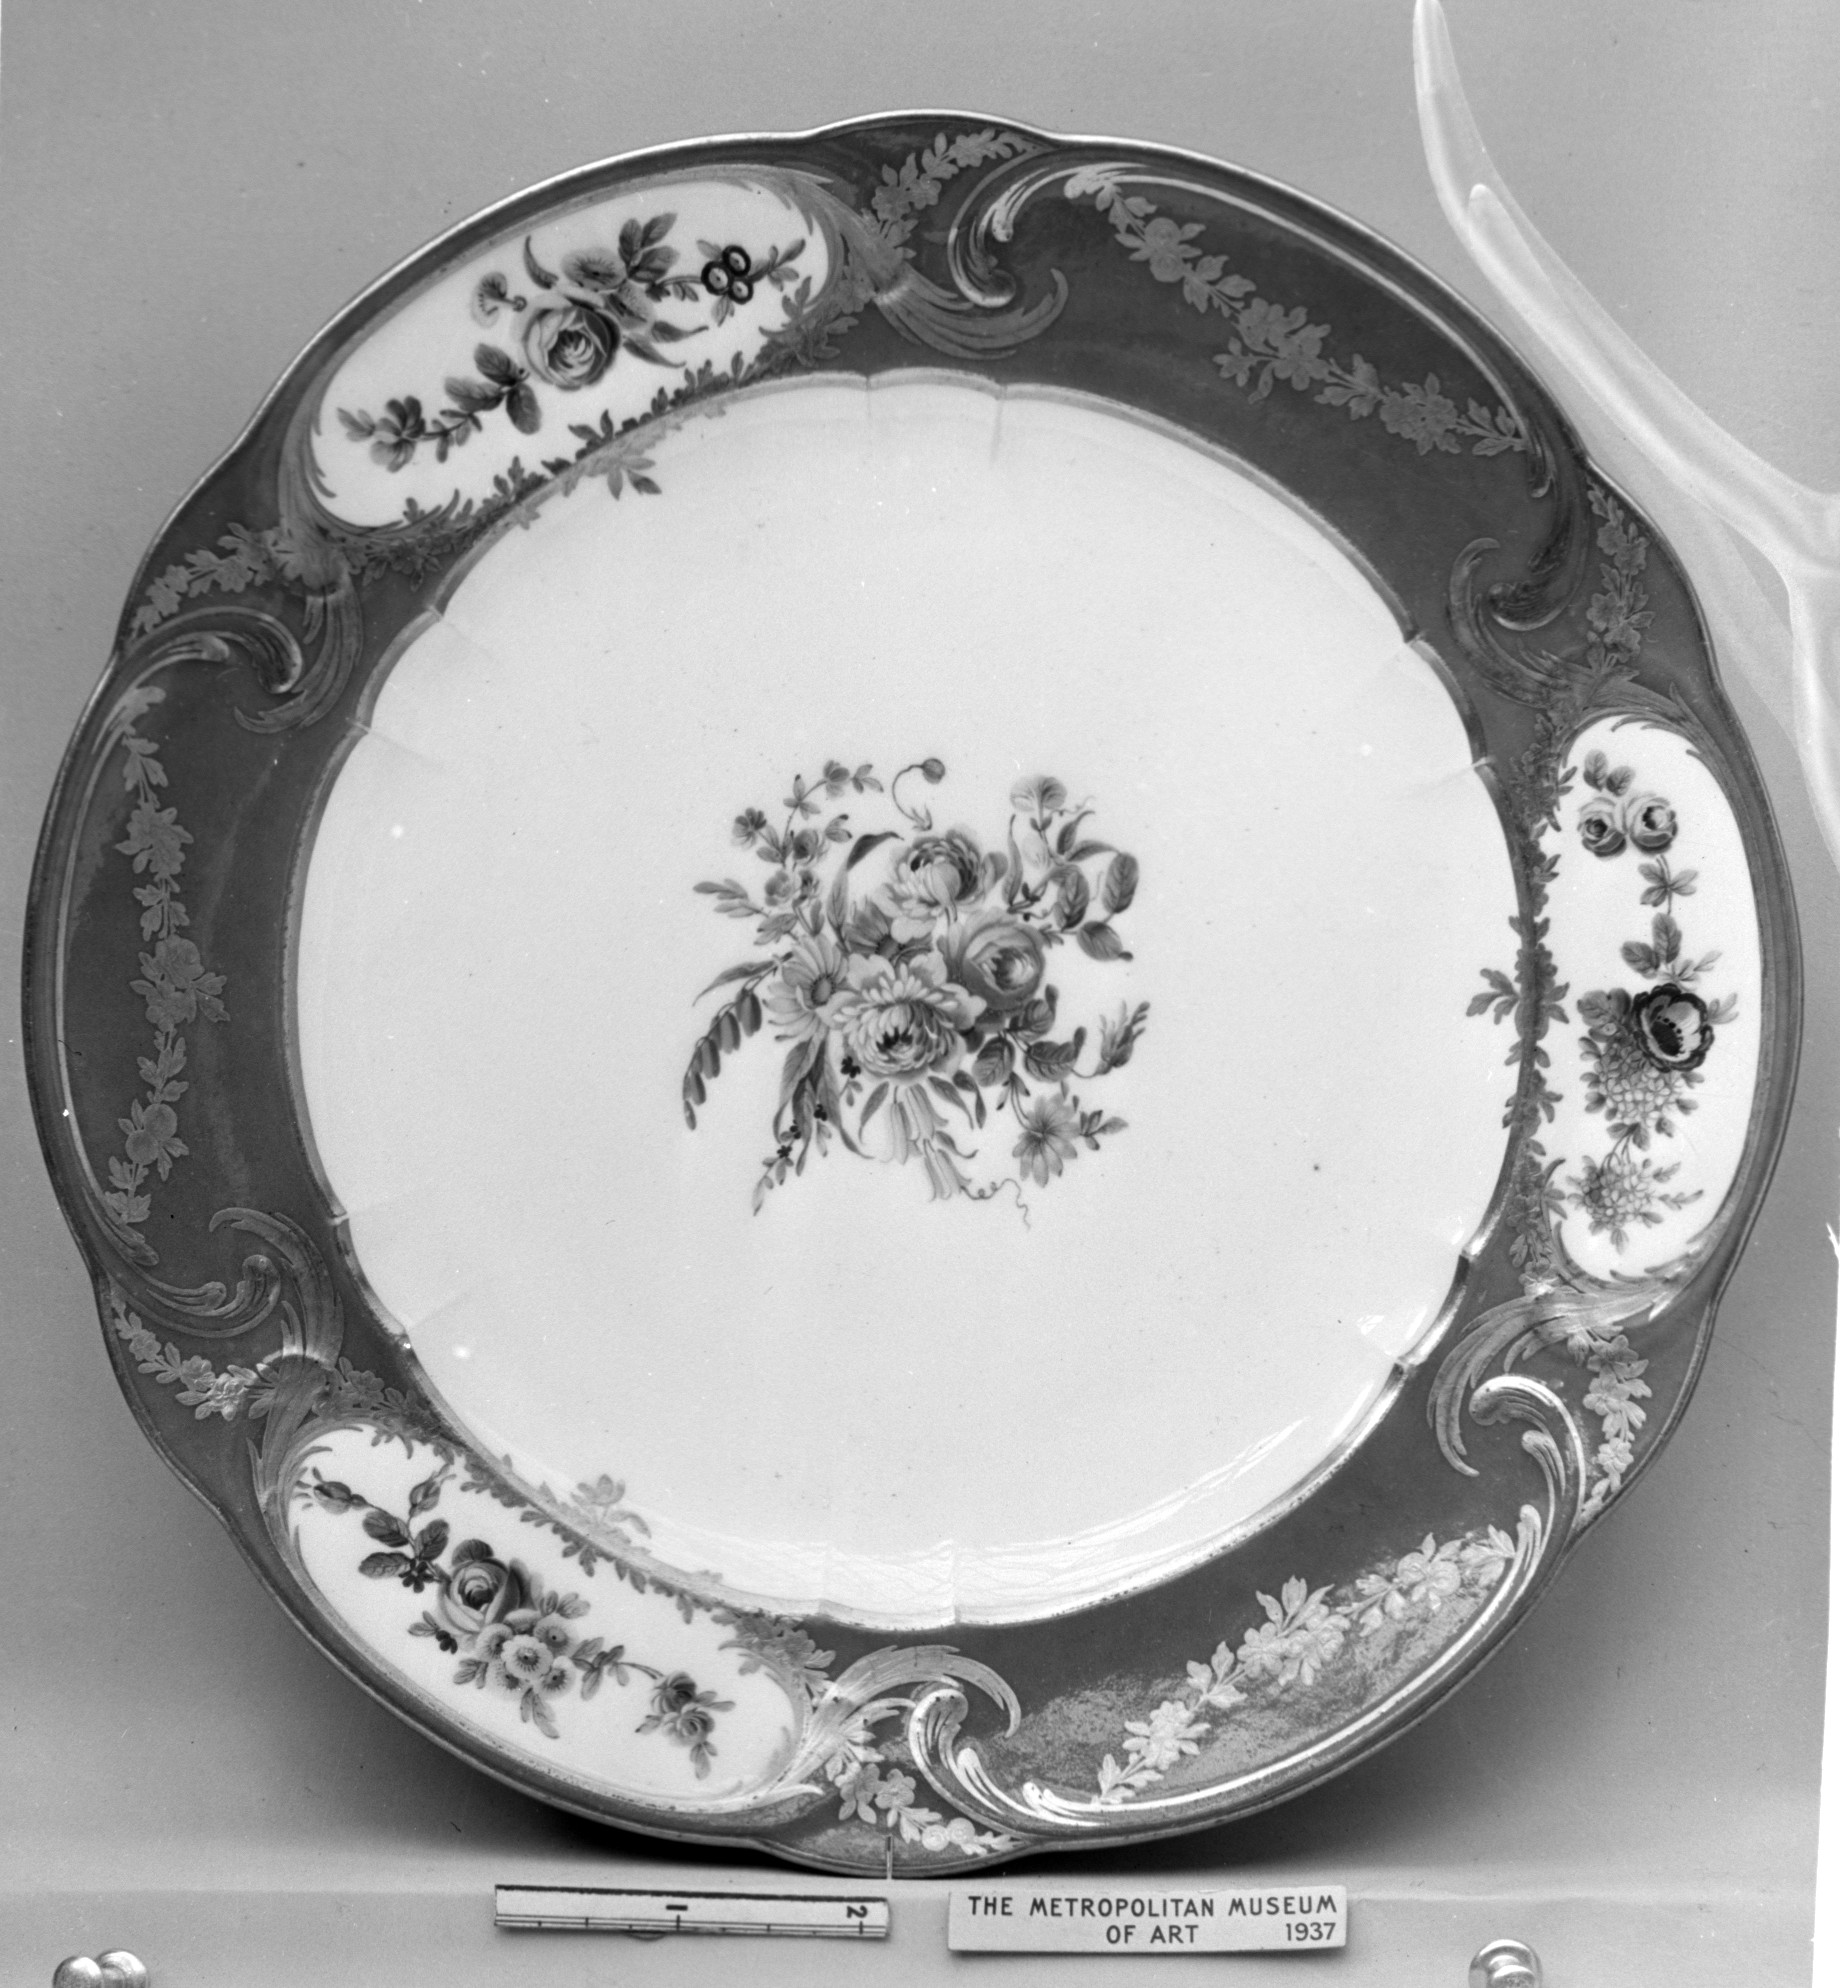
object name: plate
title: Plate (Assiette à palmes) (1 of 102) (part of a service)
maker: sèvres manufactory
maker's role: manufactory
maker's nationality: french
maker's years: 1740-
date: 1772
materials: soft paste porcelain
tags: flowers